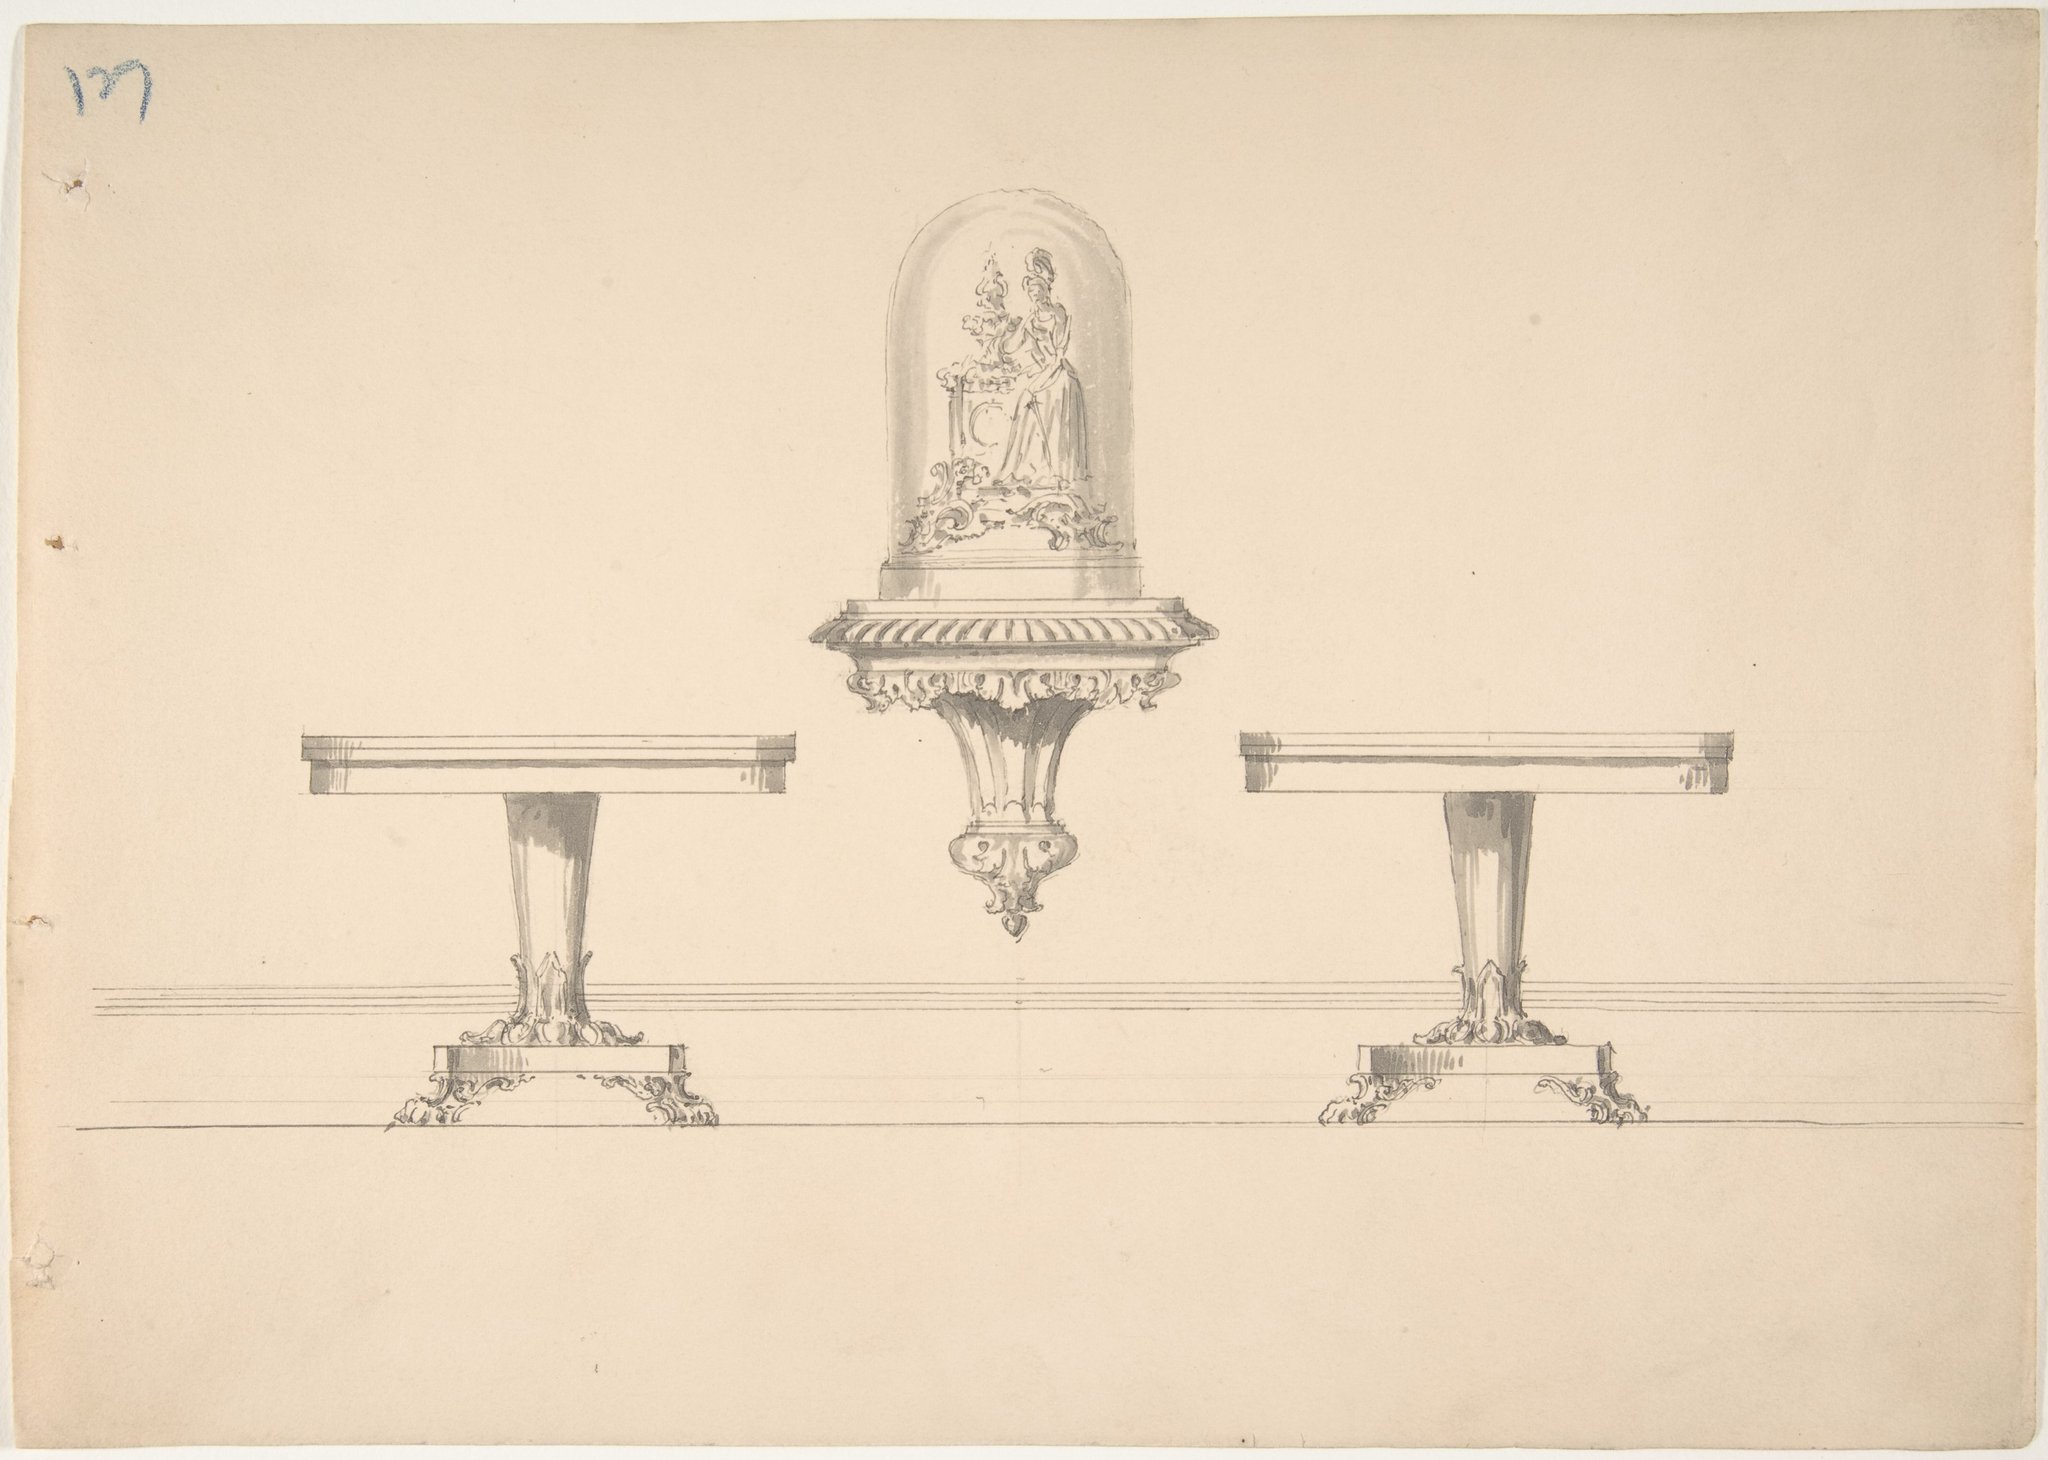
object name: drawing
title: Design for Two Round Pedestal Tables and Rococo-style Carved Shelf Supporting a Clock under Glass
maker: anonymous, british, 19th century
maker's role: artist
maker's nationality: british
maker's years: 1800-1900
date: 1801-1833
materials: ink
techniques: brush, pen, wash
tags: women,clocks,furniture,tables